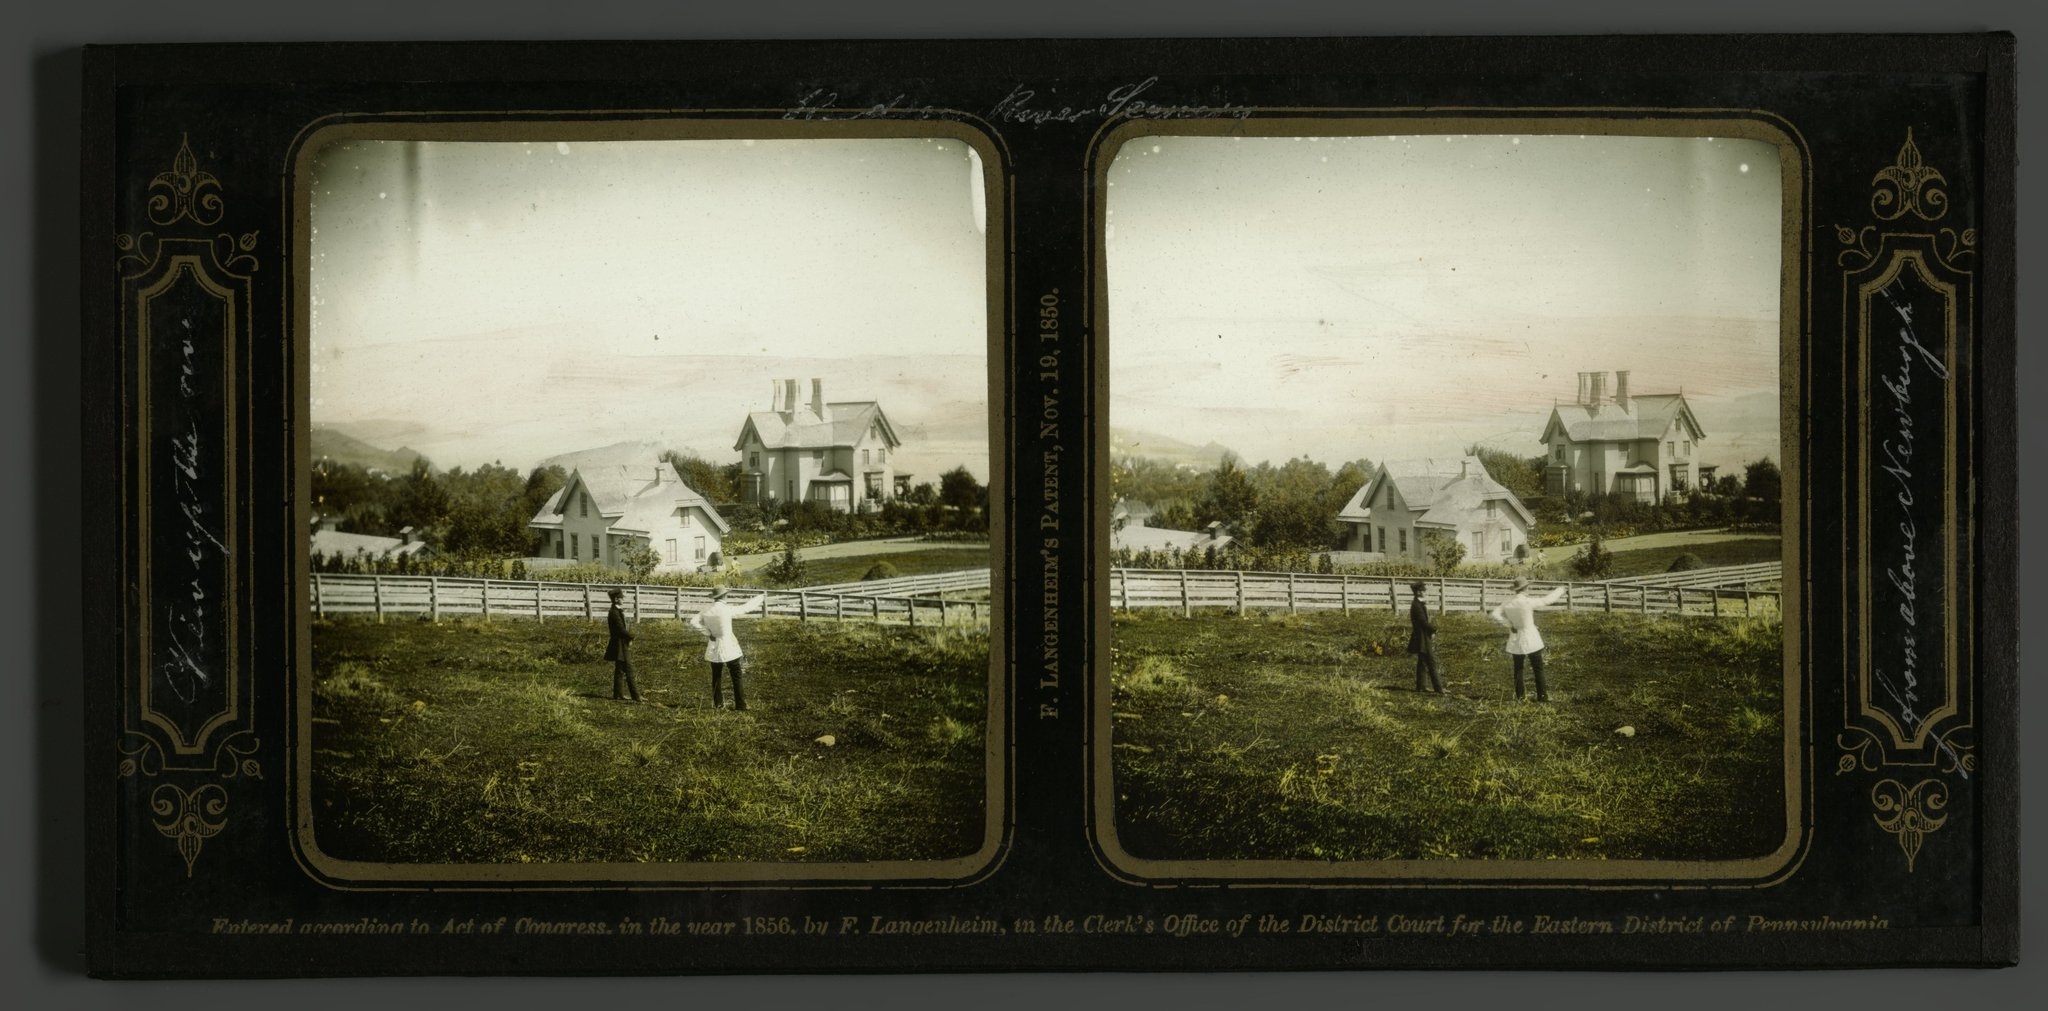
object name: stereoscopic photograph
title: Hudson River scenery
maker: frederick langenheim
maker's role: fotograaf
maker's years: 1809-1879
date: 1856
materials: glass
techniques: hand coloring, slide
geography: newburgh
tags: village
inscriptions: inscription: ‘F. Langenheim's Patent, Nov. 19, 1850.’, inscription: ‘Entered according to Act of Congress, in the year 1856, by F. Langenheim, in the Clerk's Office of the District Court for the Eastern District of Pennsylvania.’